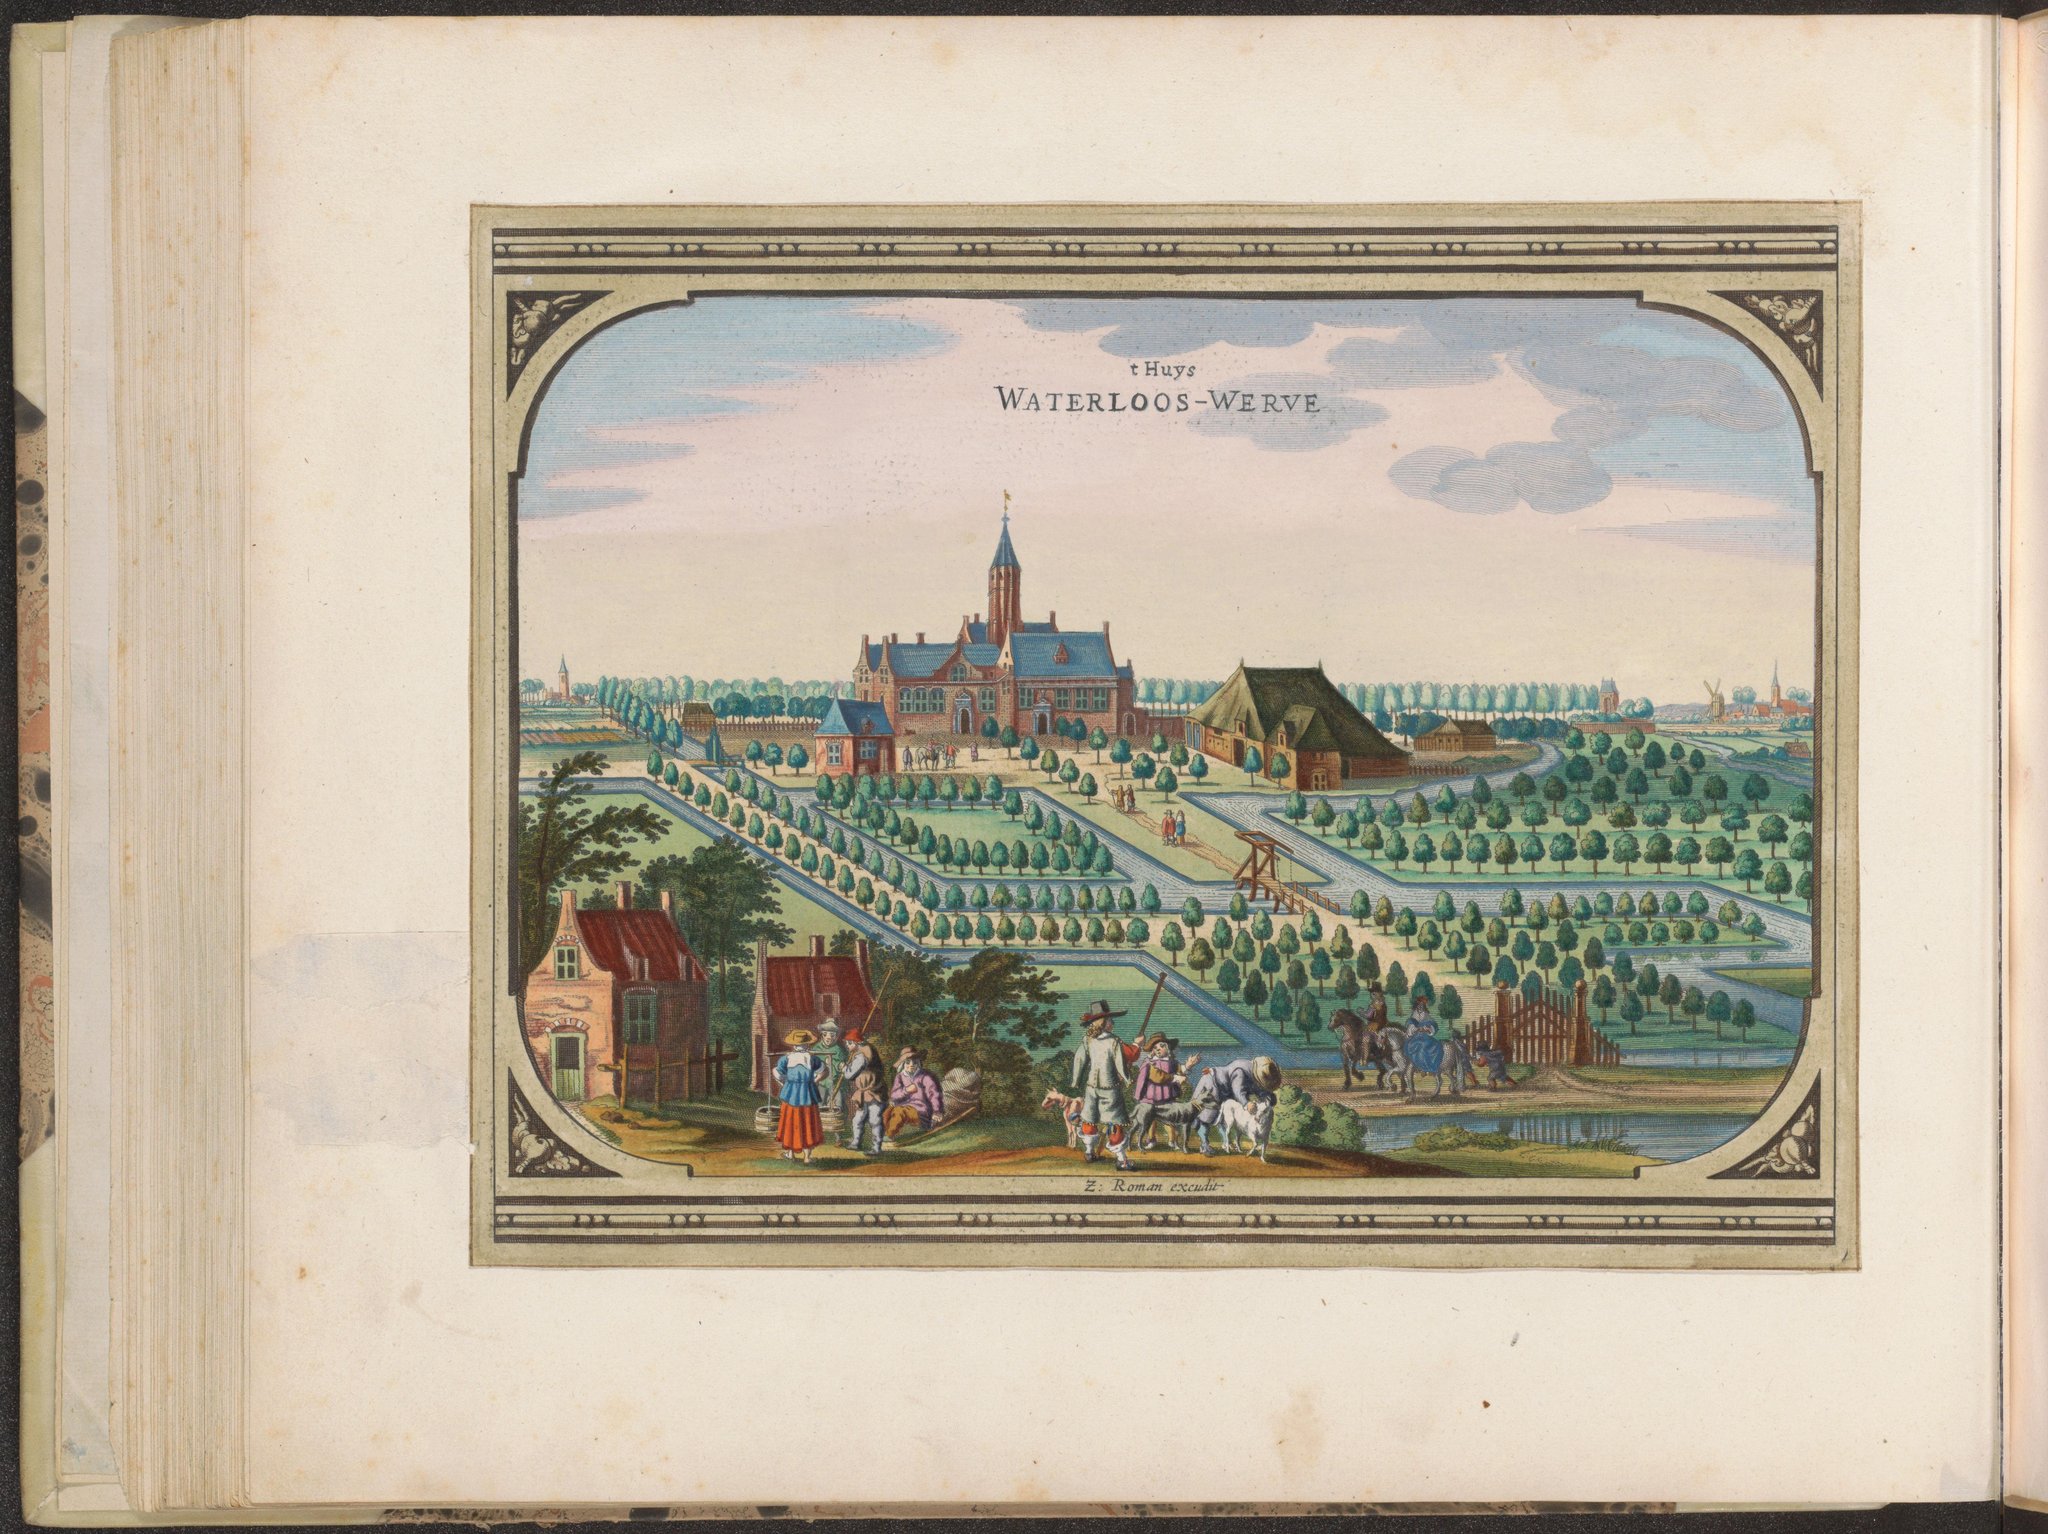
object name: album leaf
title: Gezicht op Huis Waterlooswerve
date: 1662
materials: paper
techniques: etching, hand coloring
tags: city-view, and landscape with man-made constructions, garden, farmers, carrying something with yoke, bridge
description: Gezicht op Huis Waterlooswerve, een buitenplaats in Aagtekerke. Op de voorgrond links twee huisjes en boeren. Een vrouw draagt twee emmers aan een juk. Rechts daarvan drie welgestelde heren met hun honden. De prent maakt deel uit van een album.